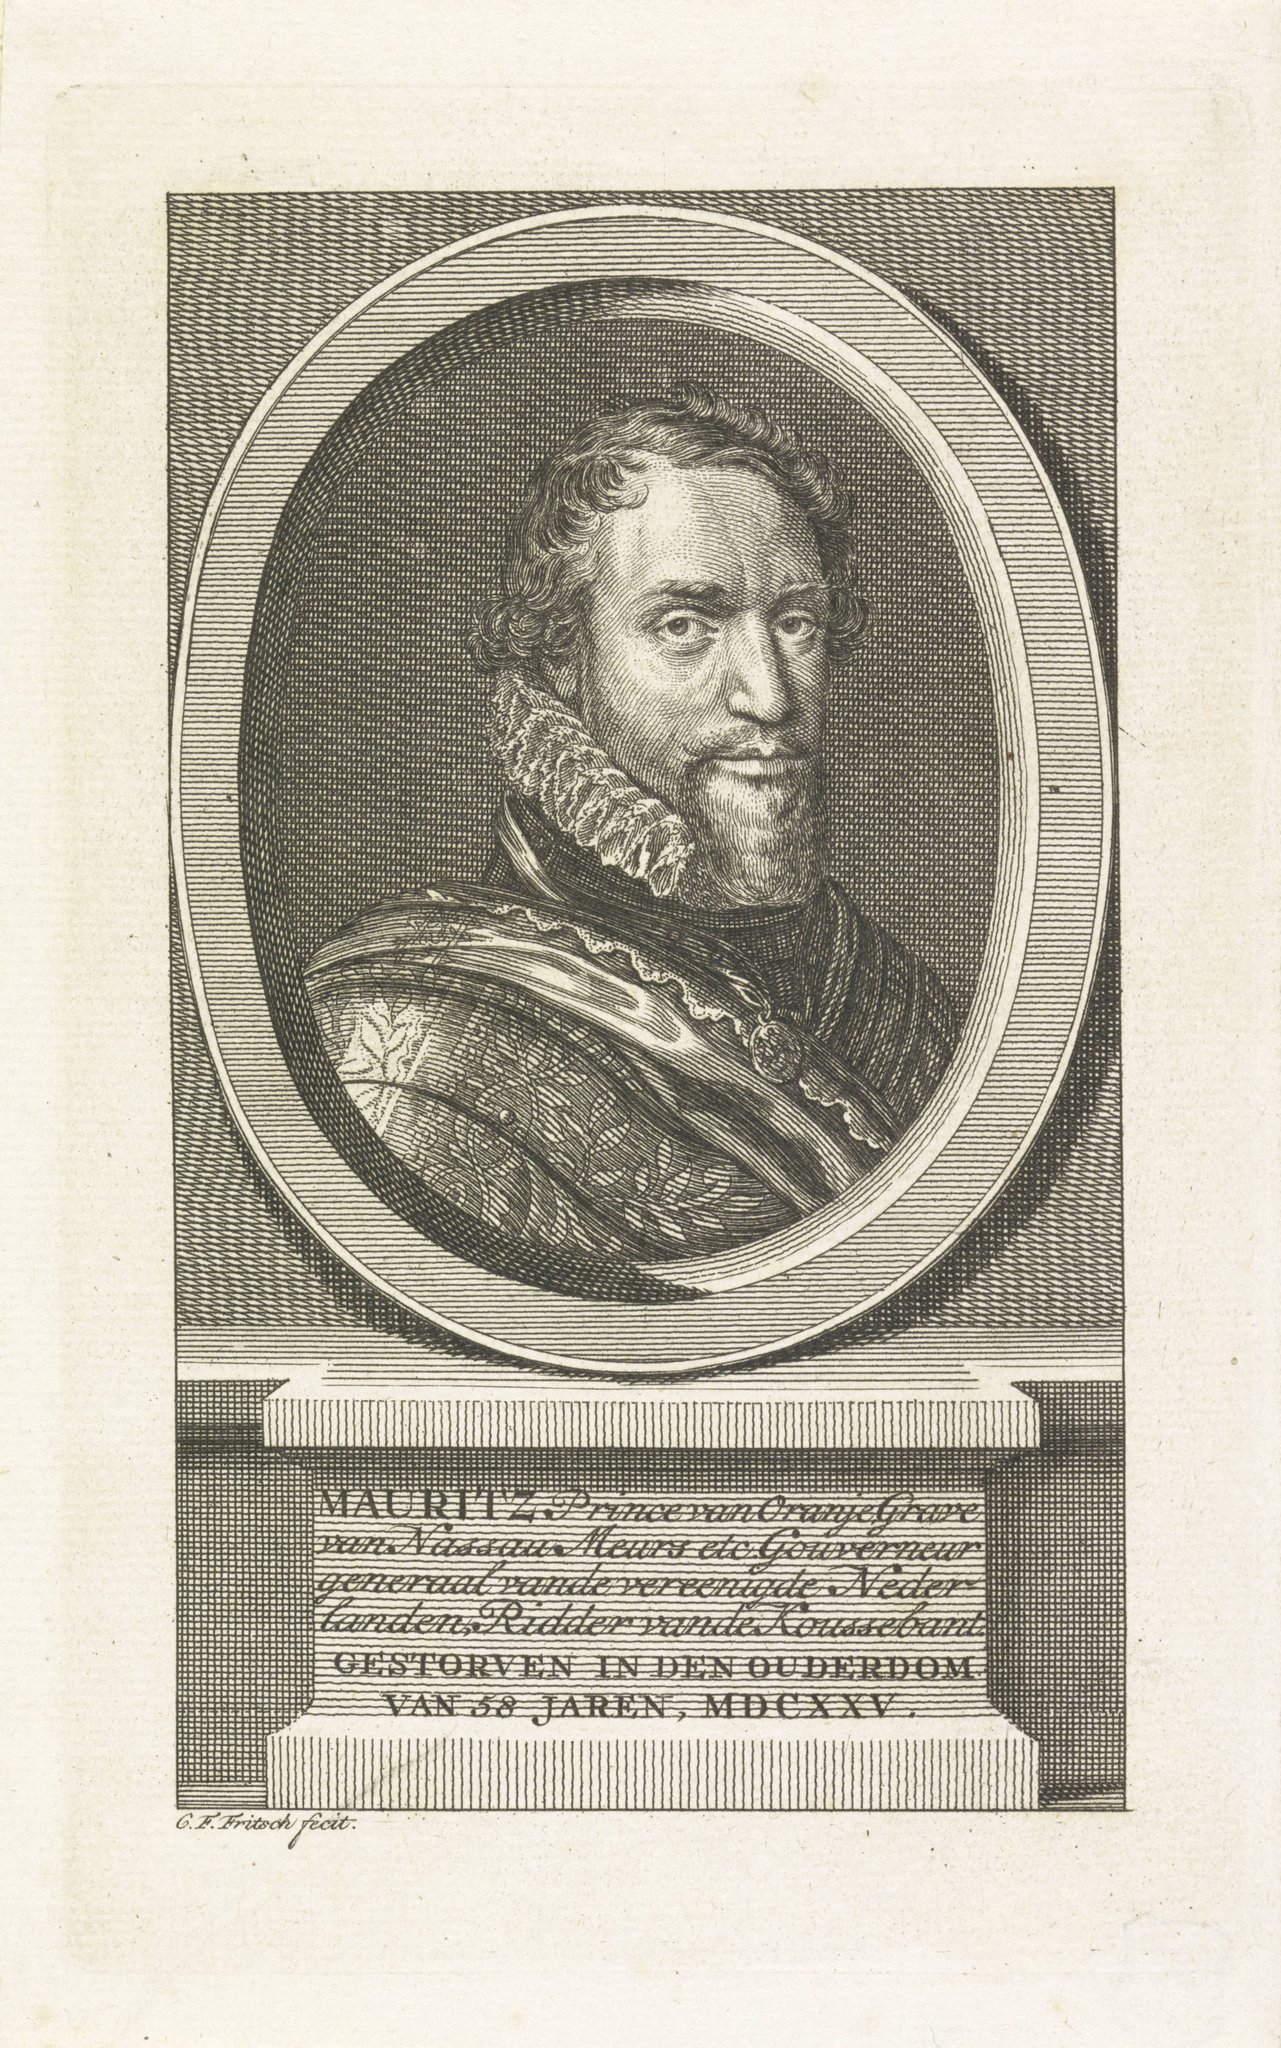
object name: print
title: Portret van Maurits, prins van Oranje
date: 1738-1774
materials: paper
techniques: engraving, etching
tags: maurice (prince of orange), knighthood order (garter) - insignia of a knighthood order, e.g.: badge, chain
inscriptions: collector's mark: Lugt 963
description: De hier vermelde titel verwijst naar de hoogst verkregen titel van de geportretteerde, niet per se naar de titel die de geportretteerde op deze voorstelling draagt.